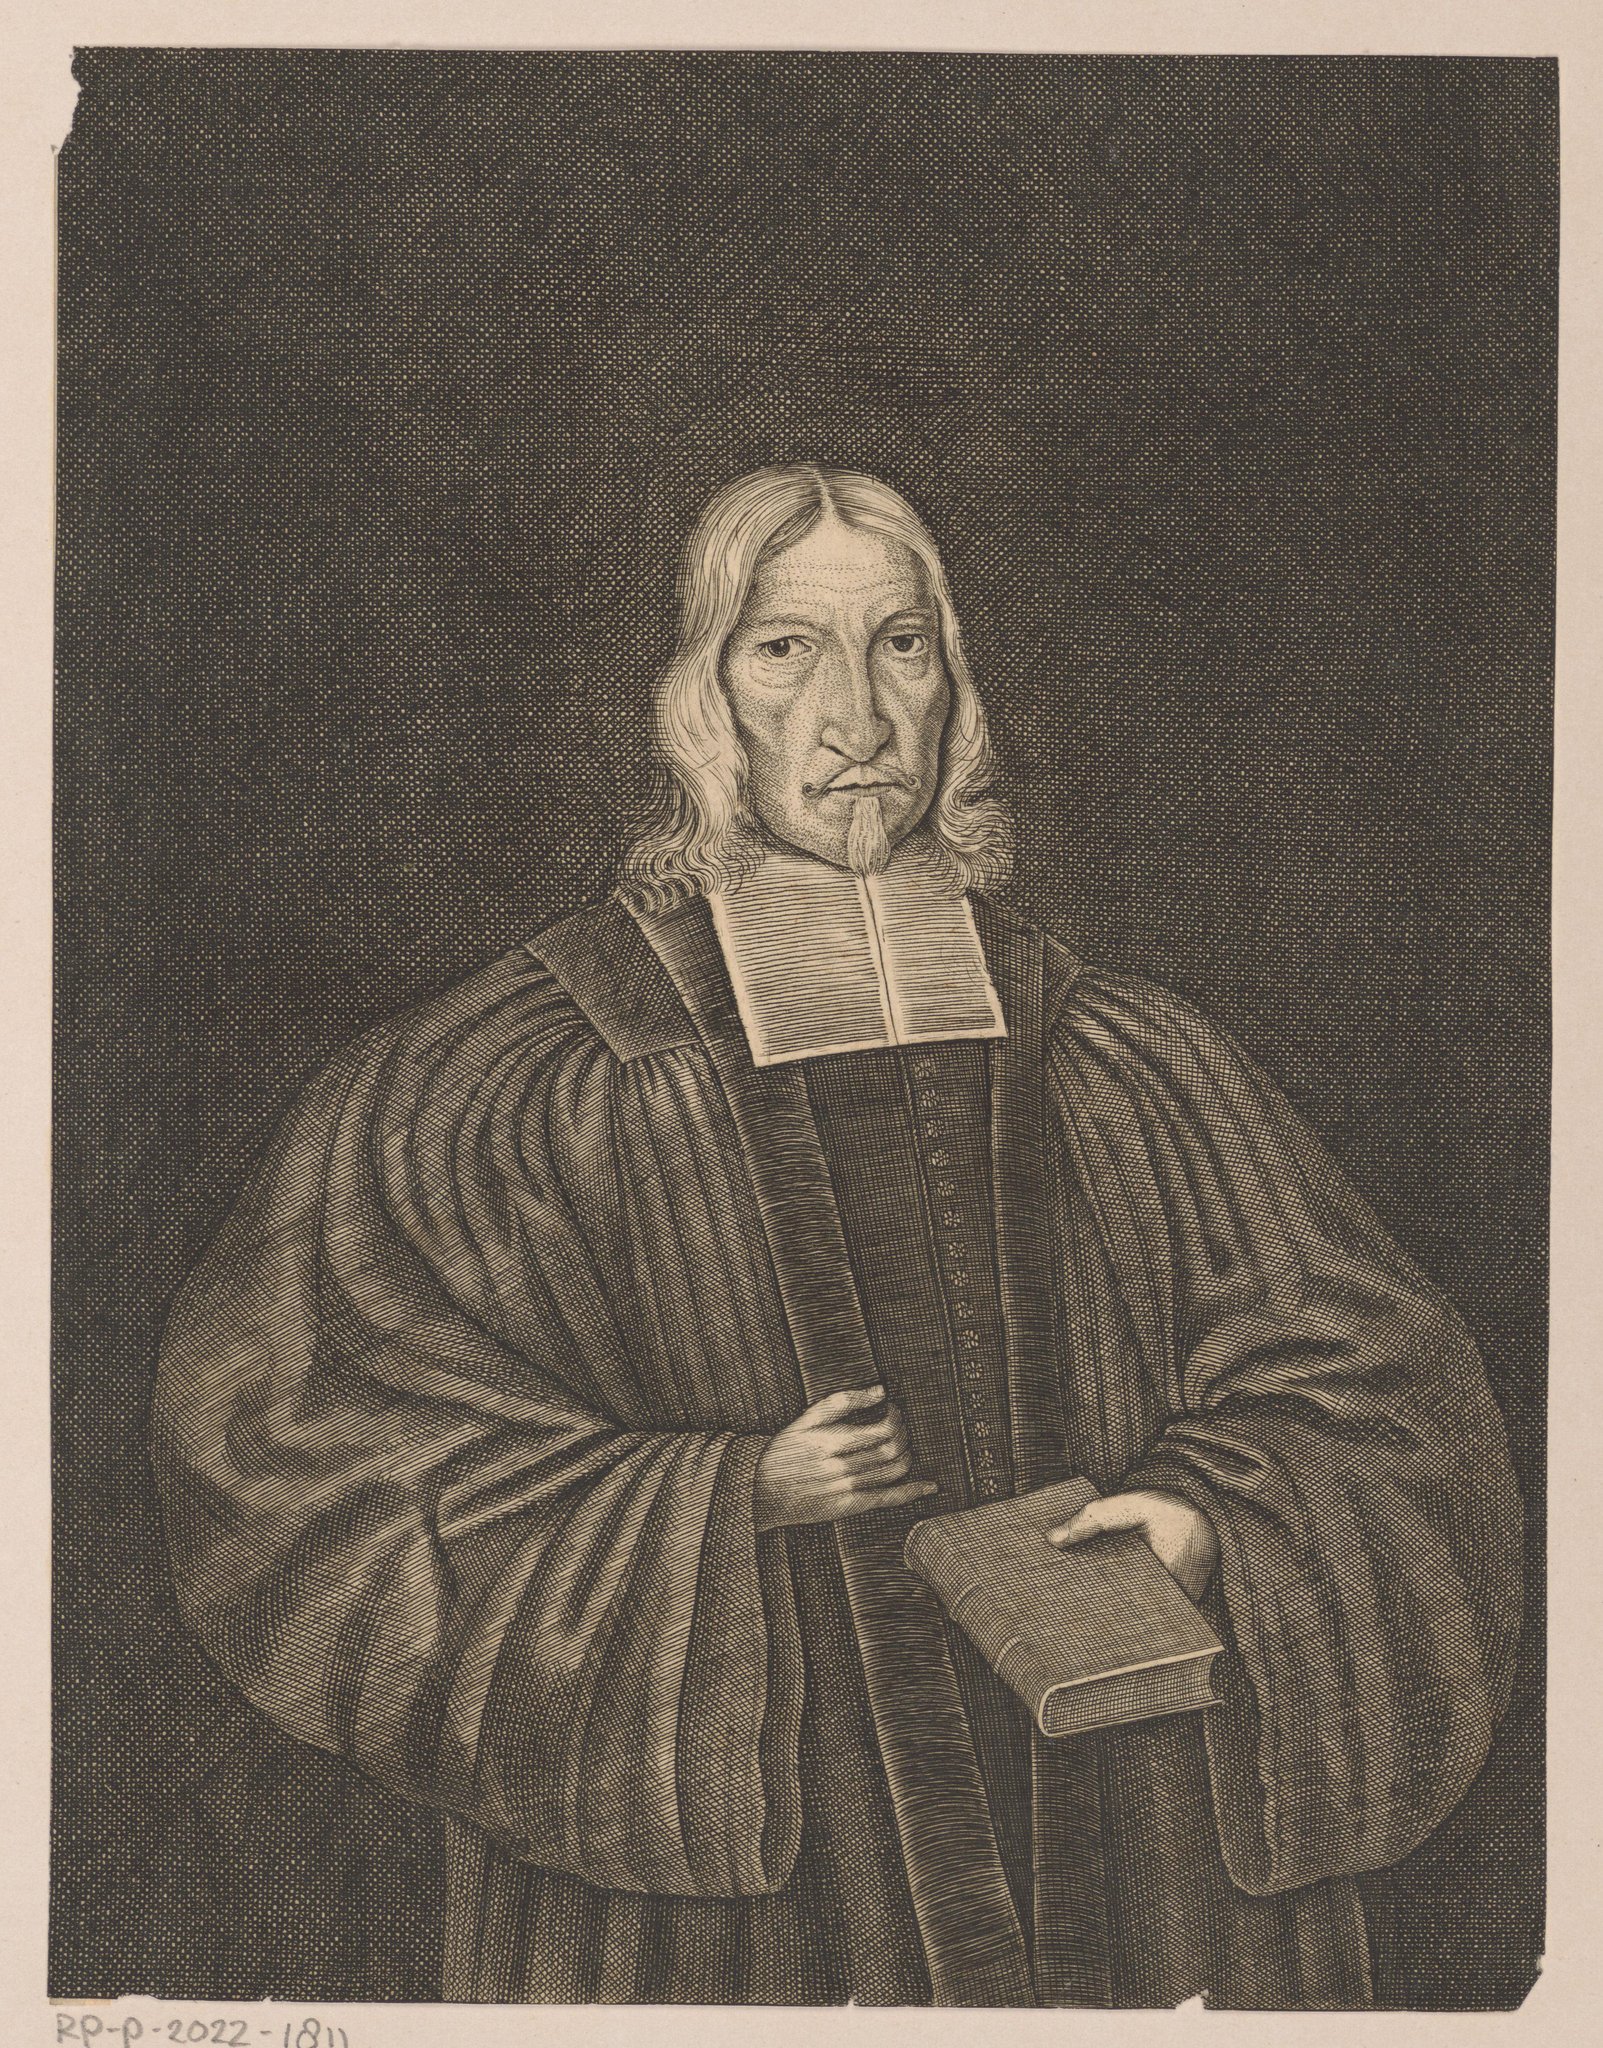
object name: print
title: Portret van Johann Andreas Quenstedt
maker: michael fennitzer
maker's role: print maker, printer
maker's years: 1641-1702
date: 1685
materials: paper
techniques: engraving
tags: theologian, historical persons, book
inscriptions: inscription: ‘n. 1617.’